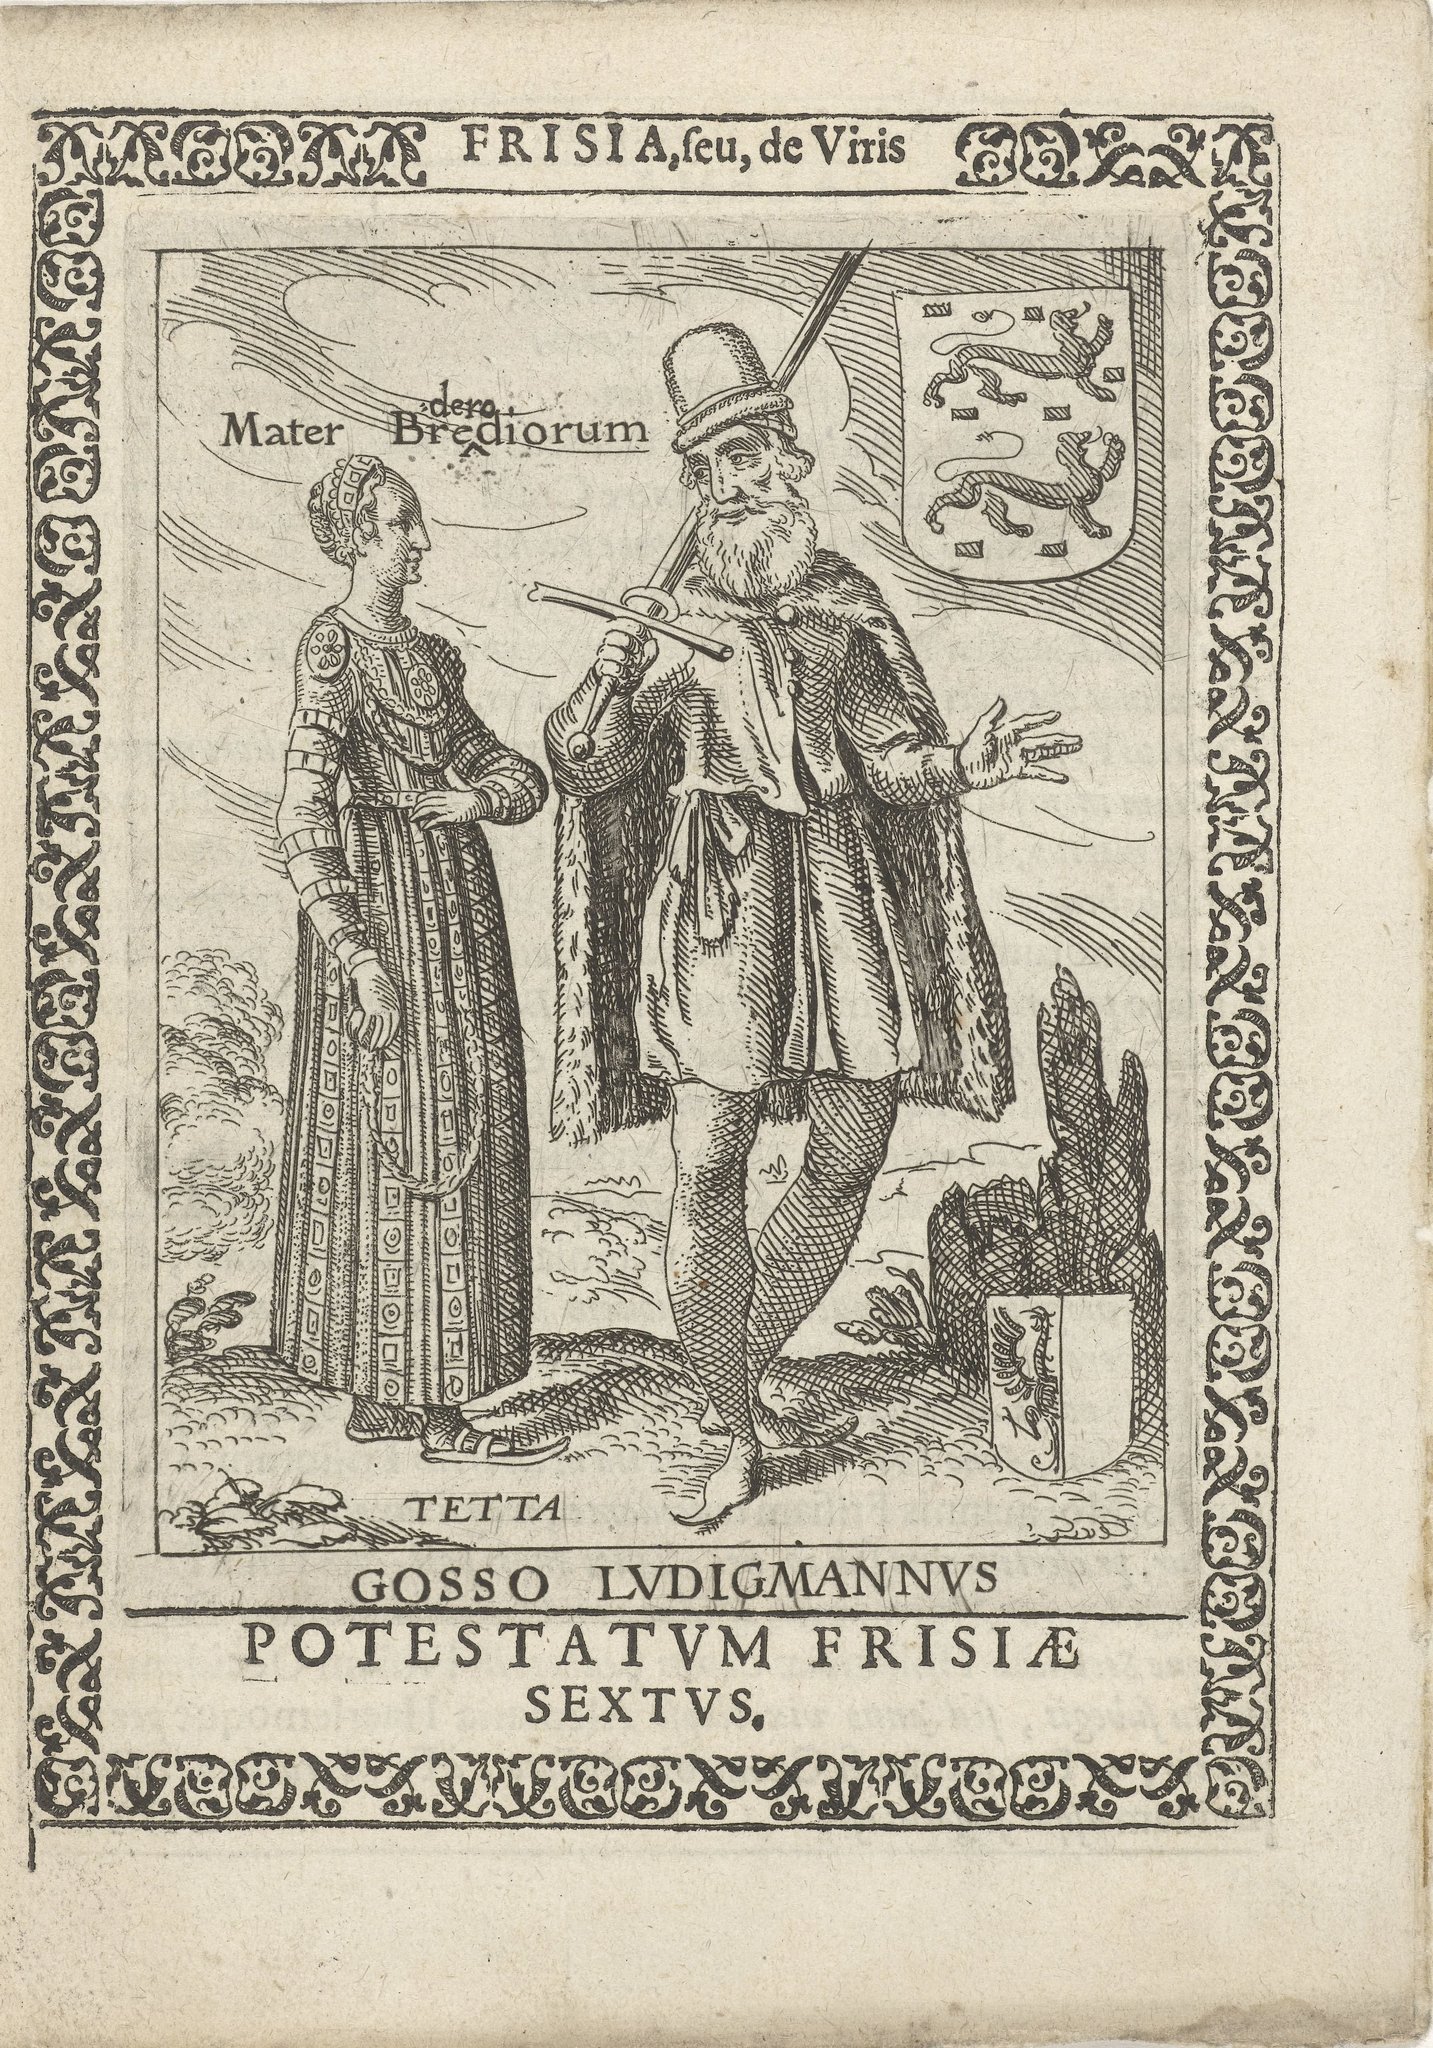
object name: book illustration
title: Frisia, sev, de Viris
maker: pieter feddes van harlingen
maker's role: painter, print maker, publisher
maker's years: 1586-1623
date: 1618-1620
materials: paper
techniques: etching, letterpress printing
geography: friesland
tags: ruler, sovereign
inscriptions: collector's mark: Lugt 2228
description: Gosso Ludigman, zesde potestaat van Friesland. Staande ten voeten uit, naast zijn vrouw Tetta Brederode. Illustratie, met tekst op achterzijde, afkomstig uit het boek: Frisia seu de viris rebusque Frisiae illustribus libri duo.